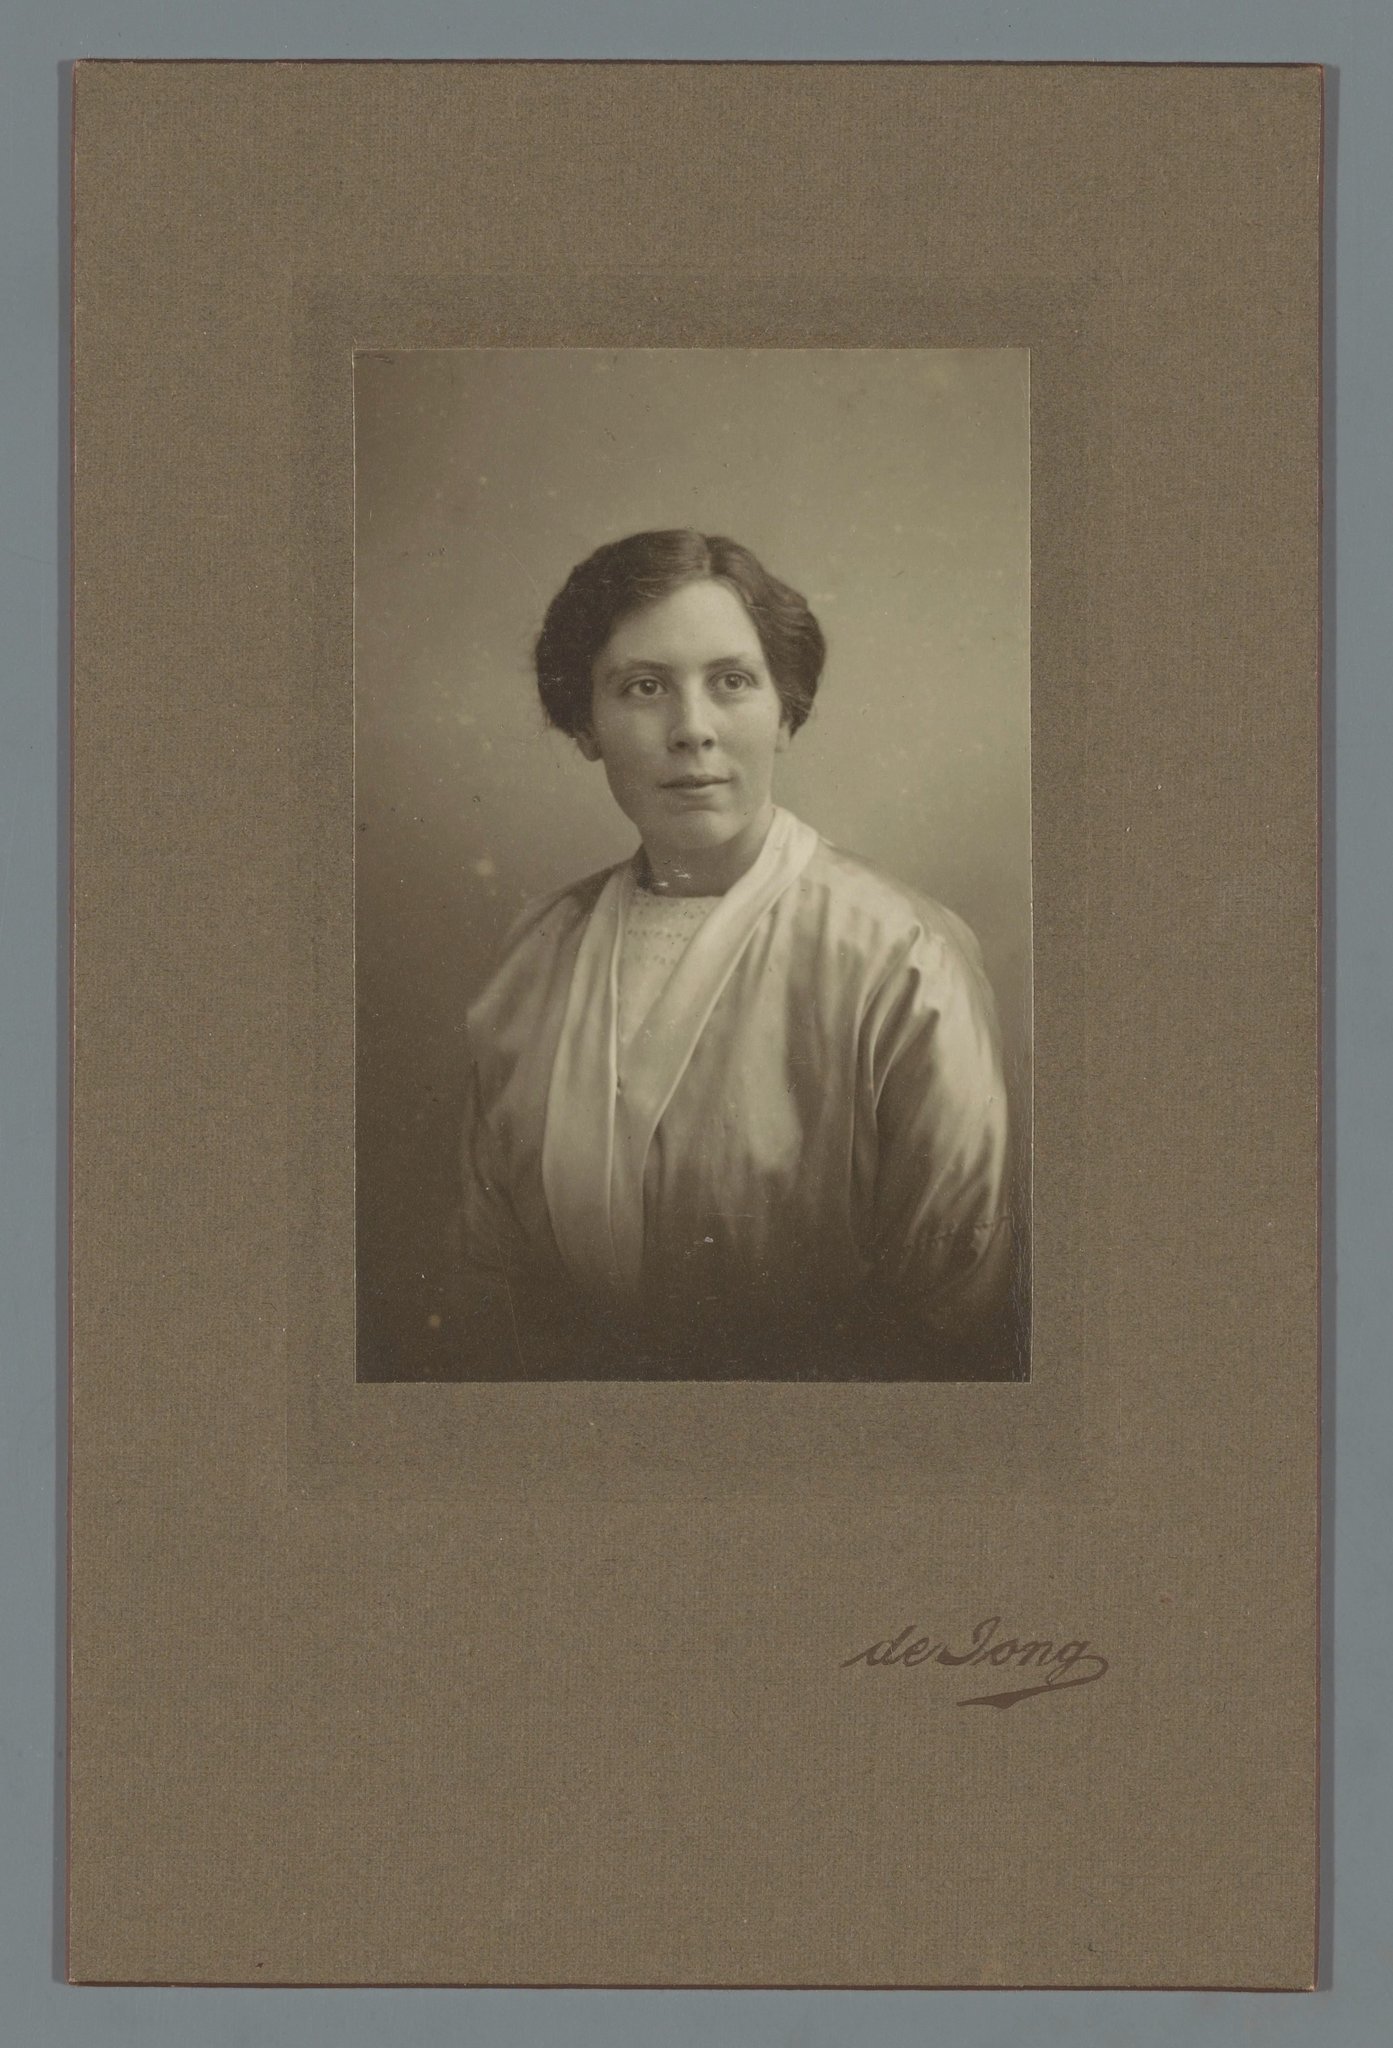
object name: cabinet photograph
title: Portret van een onbekende vrouw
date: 1880-1920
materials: cardboard, photographic support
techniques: gelatin silver print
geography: netherlands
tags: adult woman